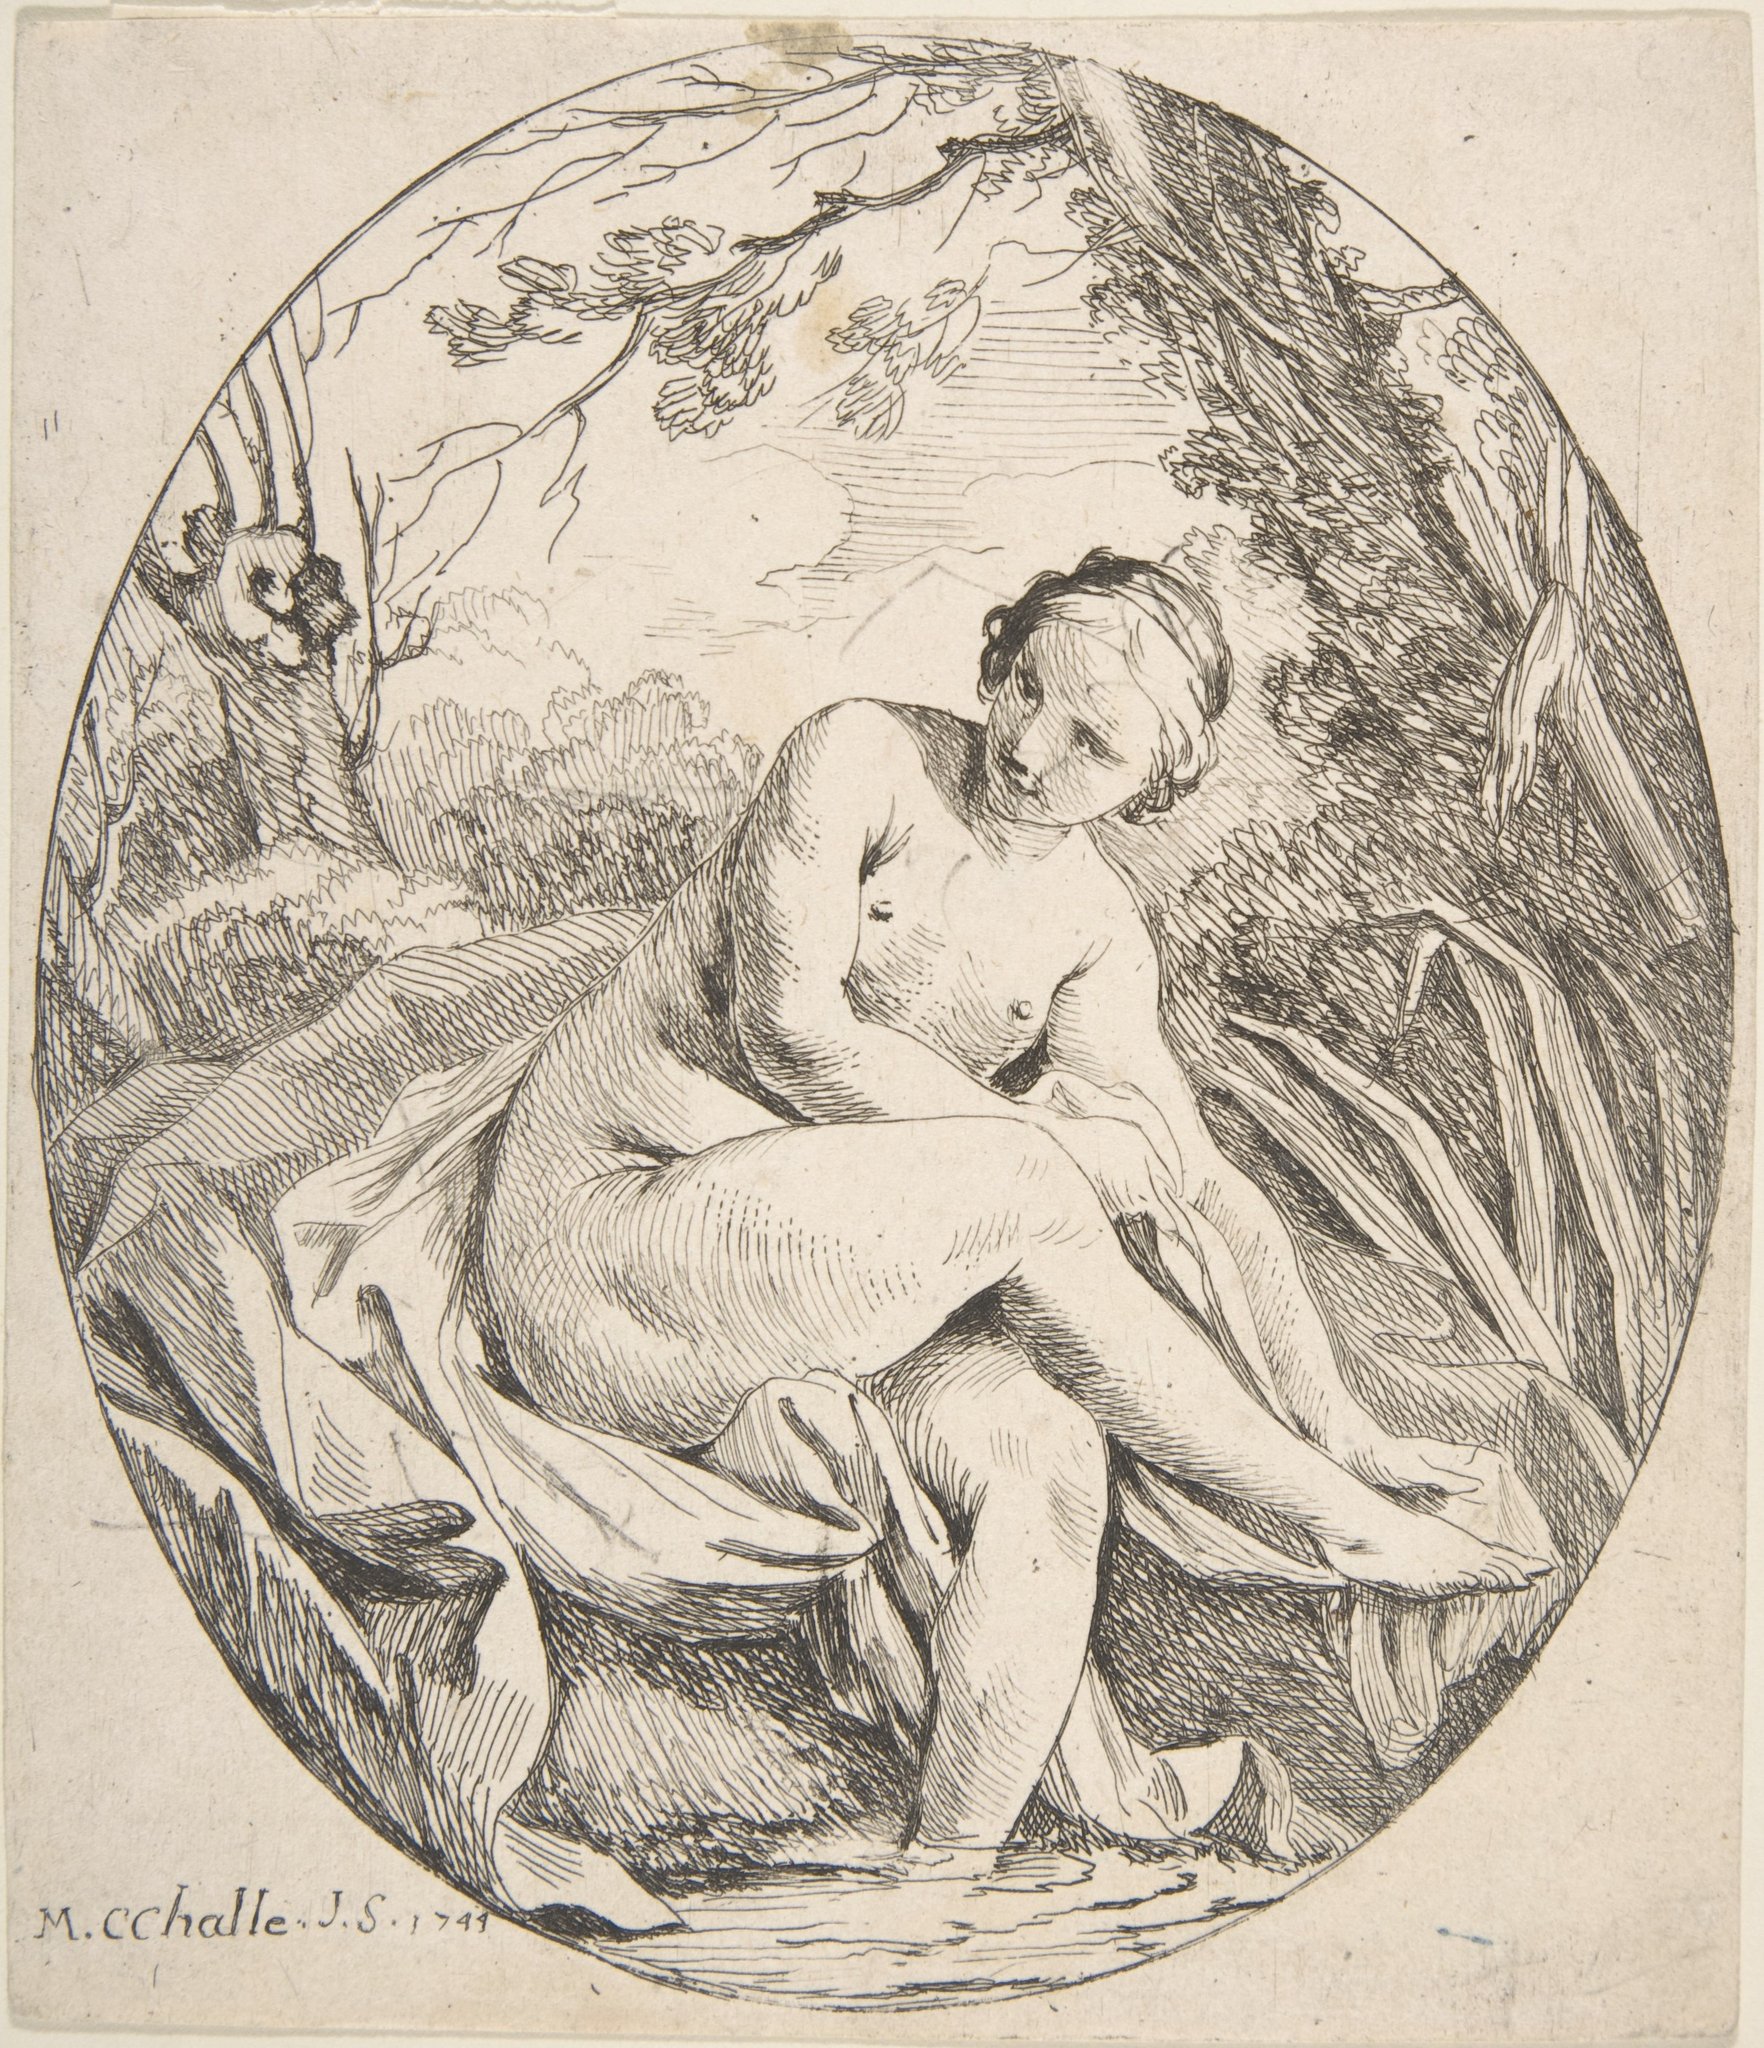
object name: print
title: Nymph at a Bath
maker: charles michel ange challe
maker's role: artist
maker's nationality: french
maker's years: 1718-1778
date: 1744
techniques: etching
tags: nymphs,bathing